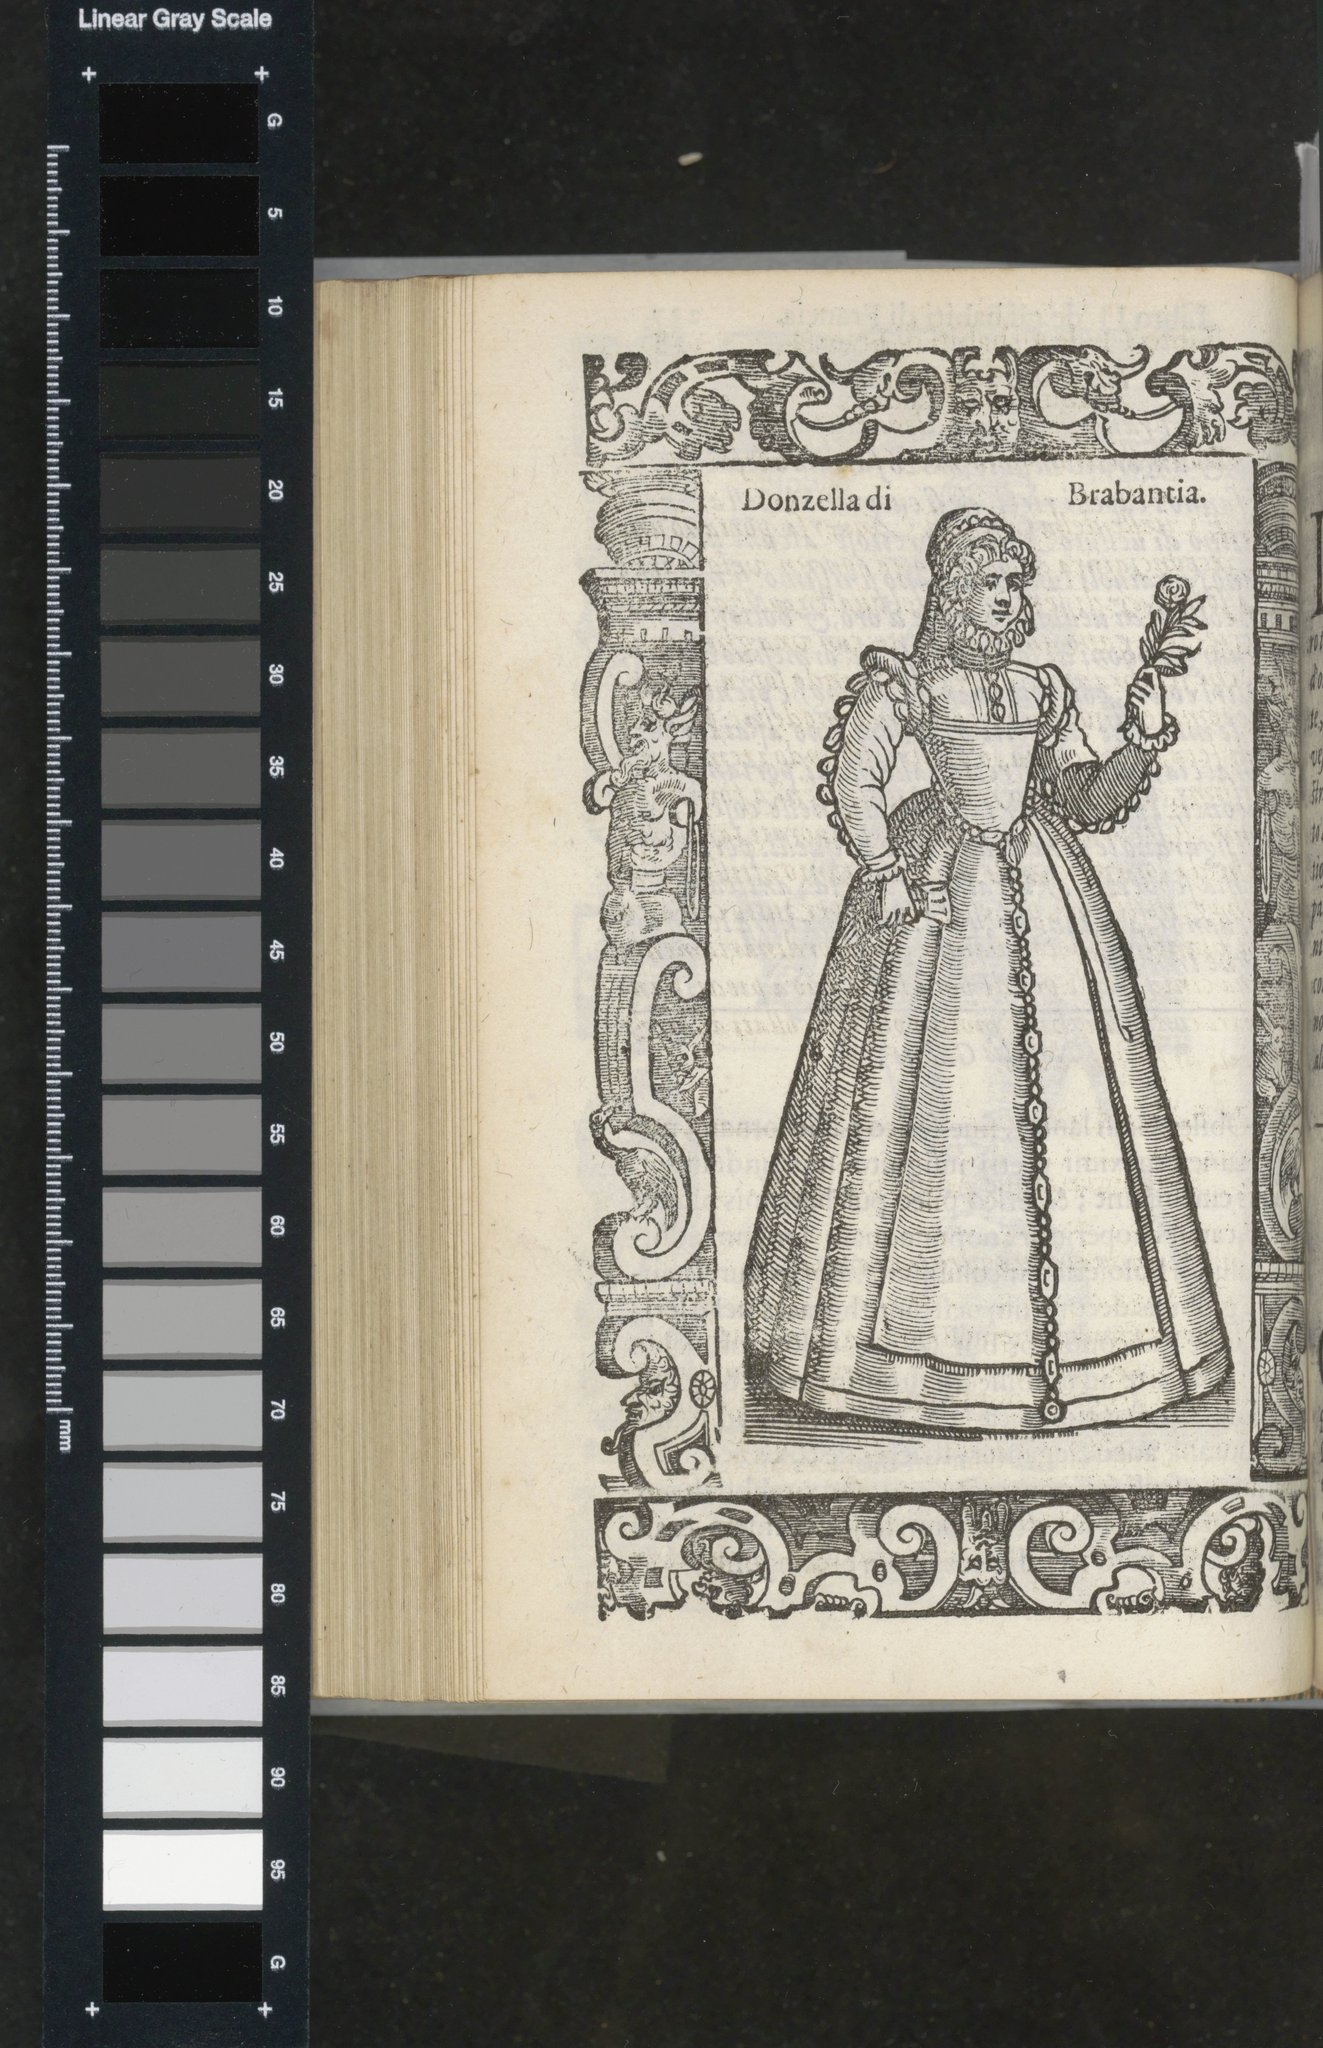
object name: costume print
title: Habiti antichi, et moderni di tutto il mondo...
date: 1598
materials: paper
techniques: woodcut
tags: fashion plates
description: Jonge vrouw uit Brabant en omgeving, speciaal Antwerpen, een bloem in de ene, een handschoen in de andere hand. Ze draagt een lang overkleed met schouderwielen waarover een schort.